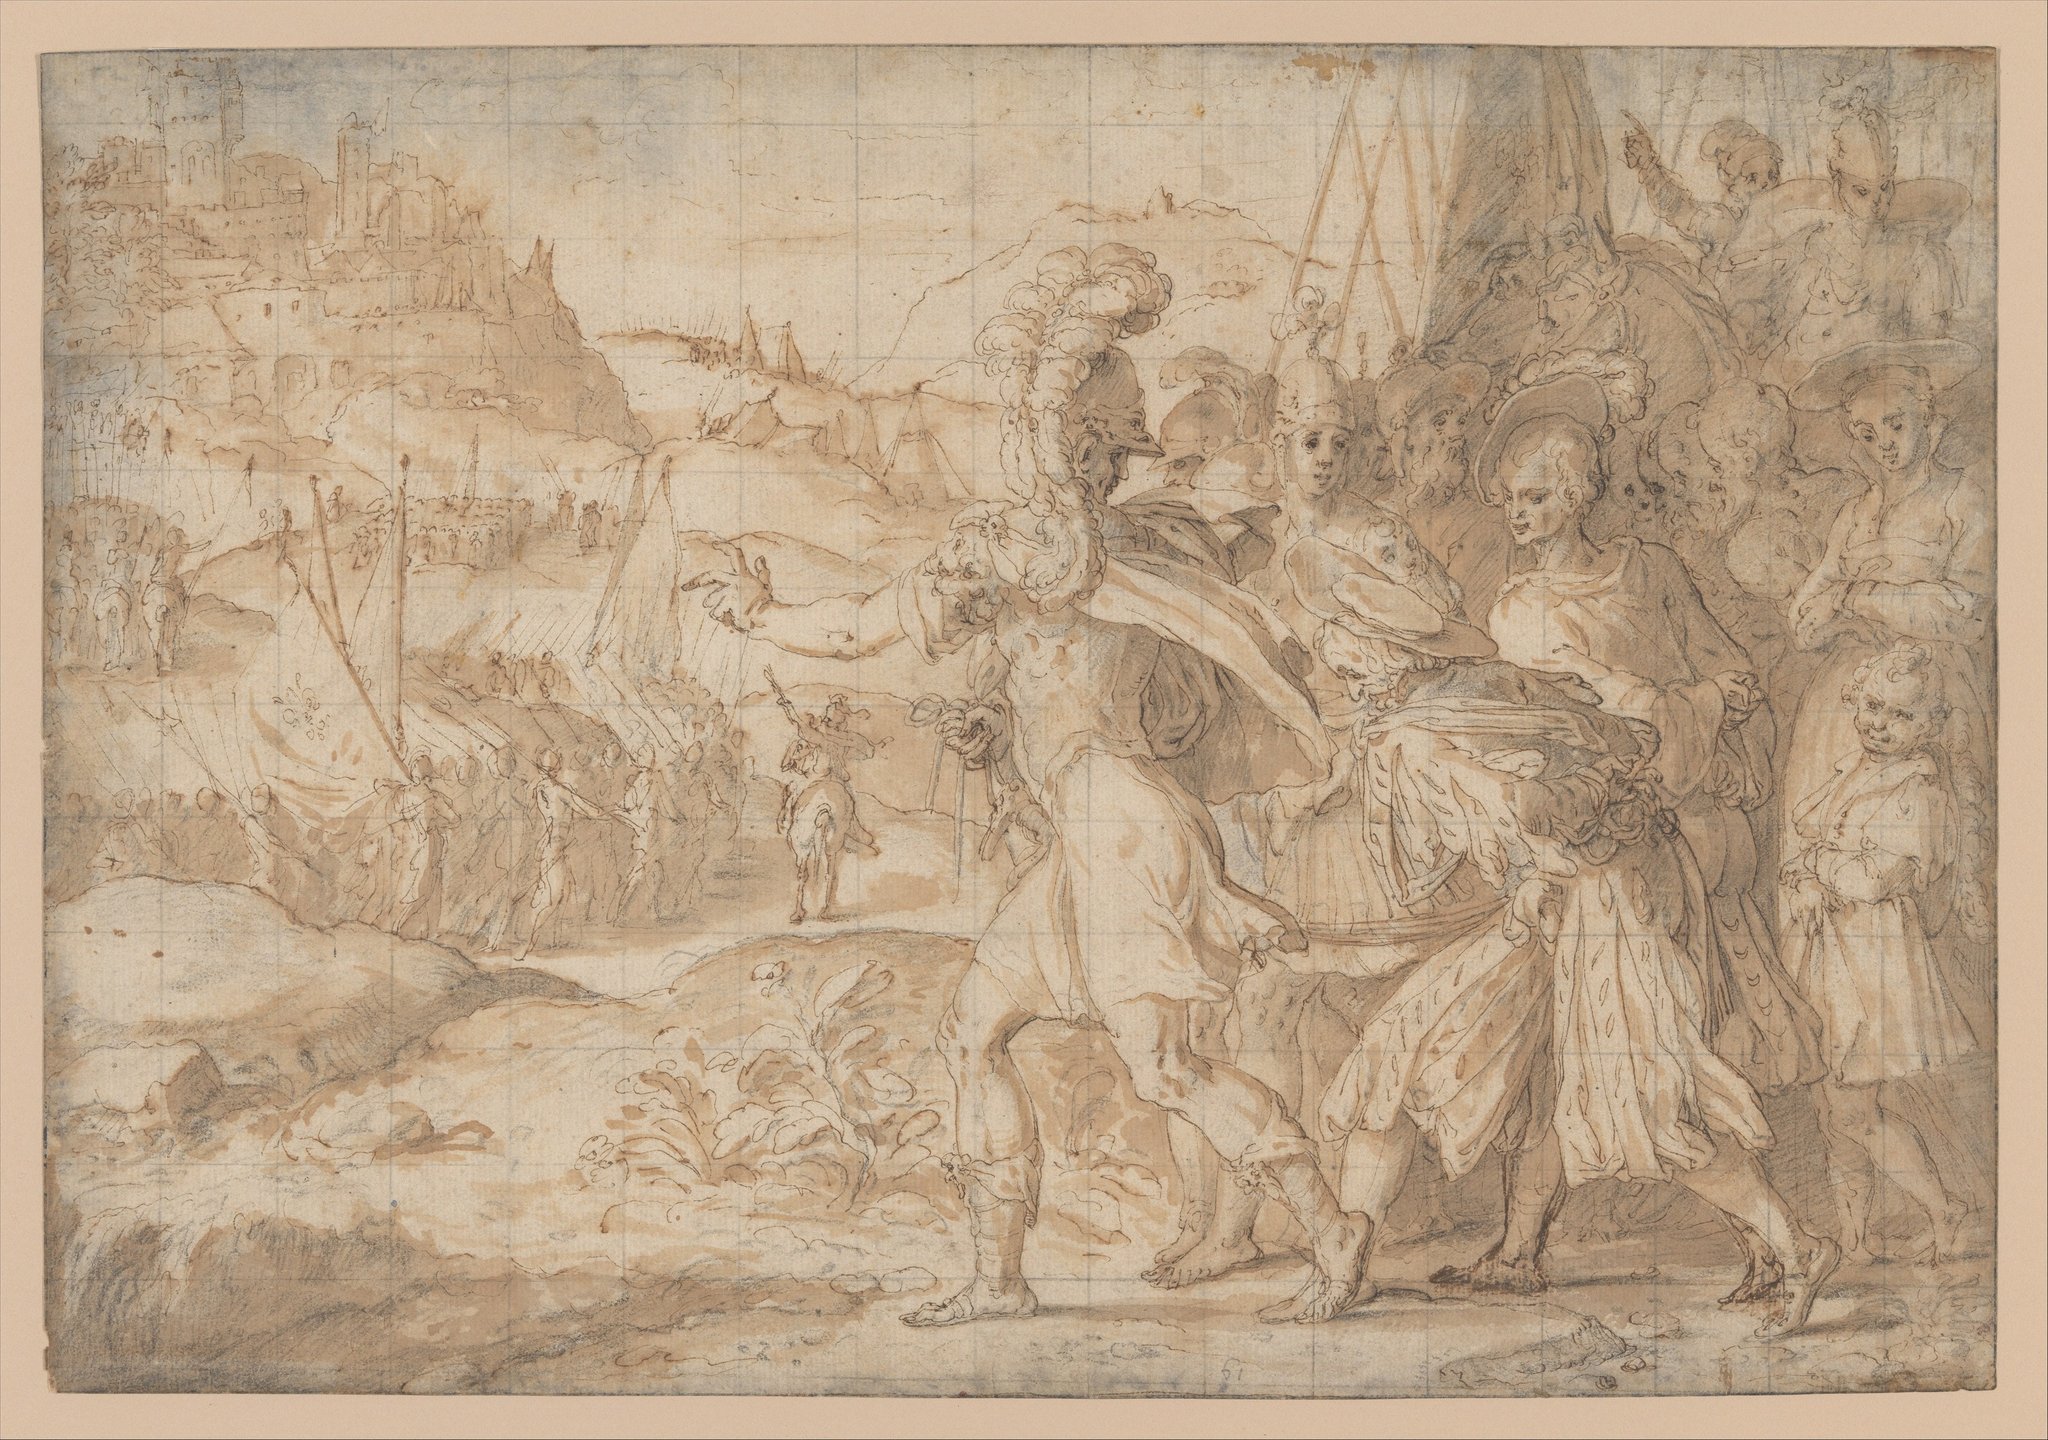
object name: drawing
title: The Siege of Fiesole by the Goths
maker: friedrich sustris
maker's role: artist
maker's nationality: netherlandish, born italy (?)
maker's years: 1535-1599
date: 1550-1599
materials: chalk, ink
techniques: brush, pen, drawing, wash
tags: buildings,soldiers,men,women